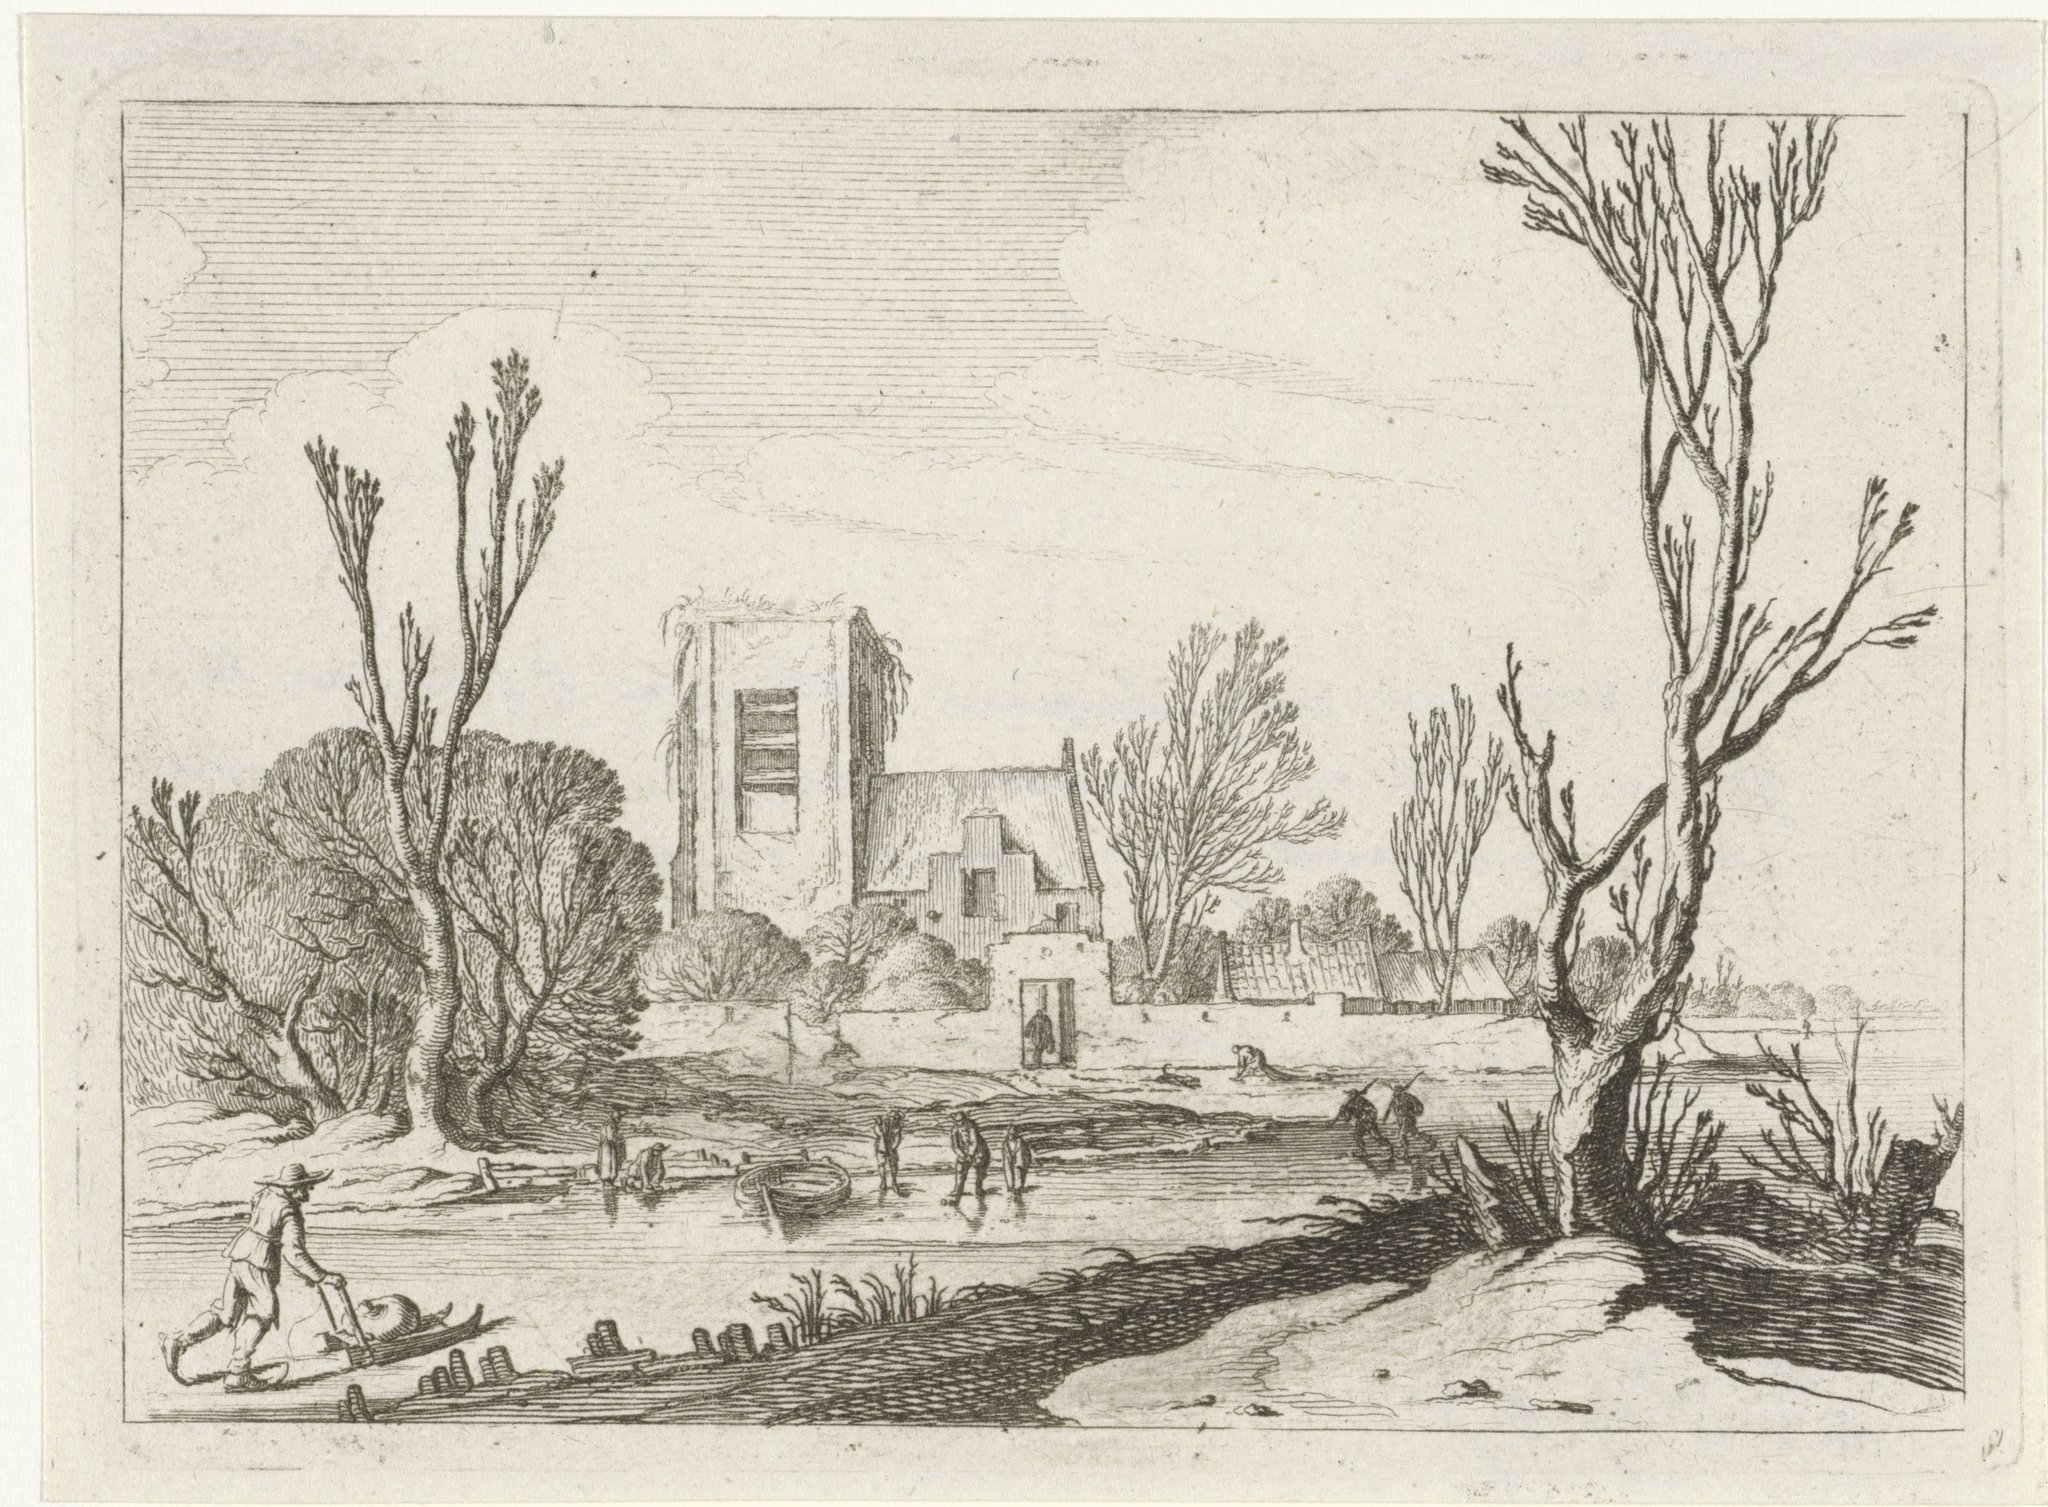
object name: print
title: Zeven landschappen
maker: gillis van scheyndel (i)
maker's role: draughtsman, print maker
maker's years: 1595-1660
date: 1631-1656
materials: paper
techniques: etching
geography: netherlands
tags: frost, freezing weather, church (exterior), winter landscape; landscape symbolizing winter (the four seasons of the year), skates (winter sports), 'kolf' on the ice, sledge, sleigh (winter sports)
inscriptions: collector's mark: Lugt 2228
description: IJsvermaak op een bevroren rivier. Op de rivier bevinden zich vissers, kolf spelende heren en schaatsers. Verderop ligt een vastgevroren schip. Op de achtergrond een dorp en een kerk zonder dak.